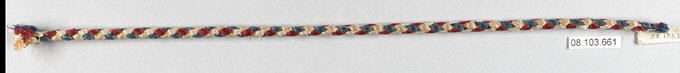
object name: cord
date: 1767-1800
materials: silk